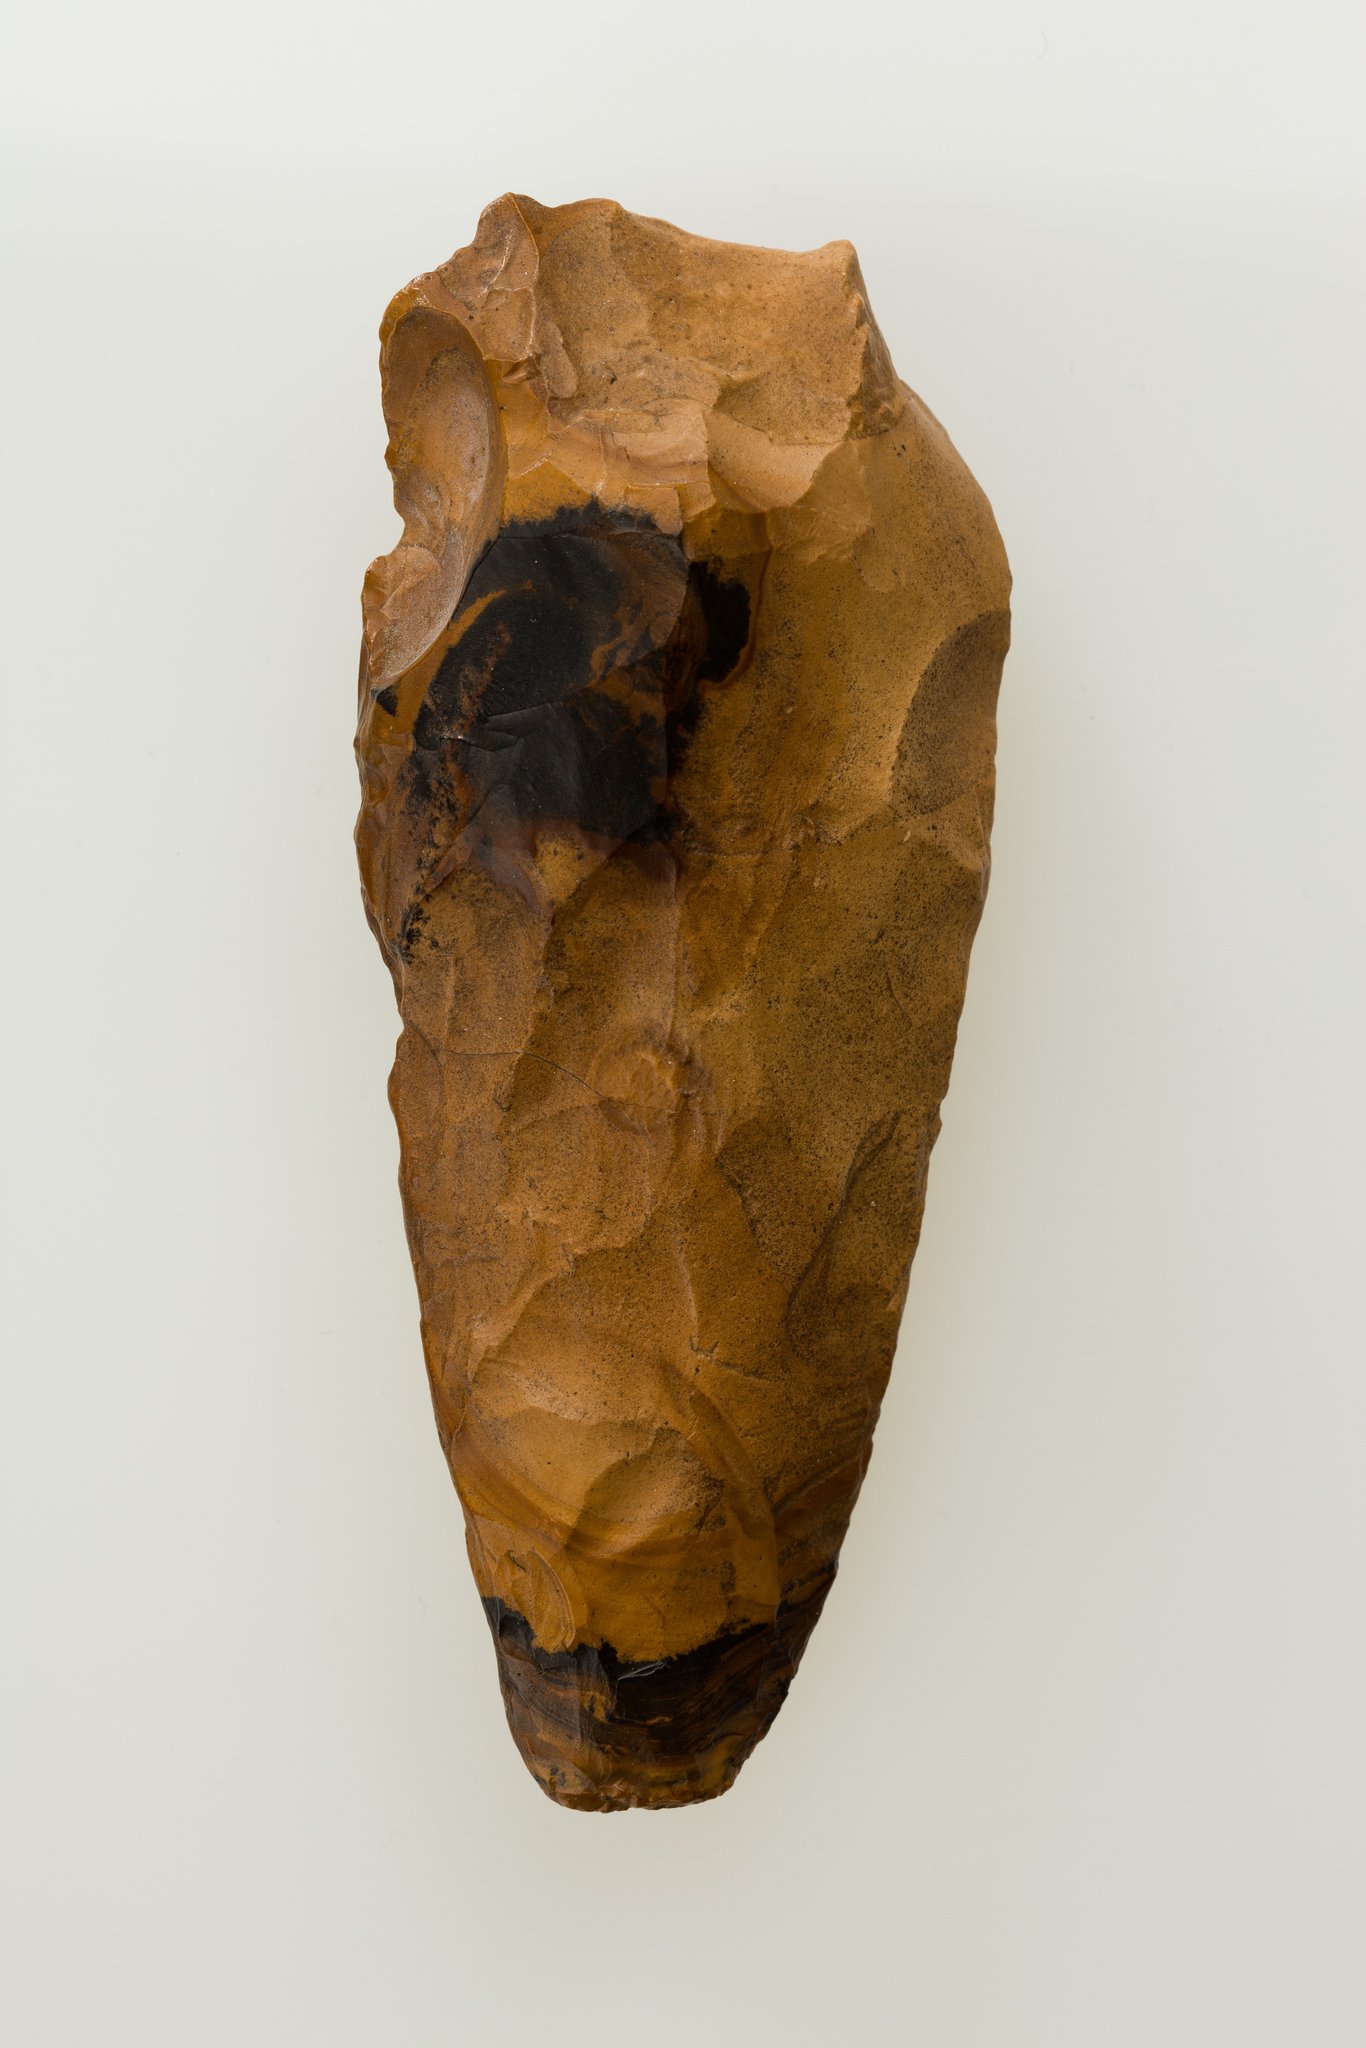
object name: tool, axe, ax, hoe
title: Ax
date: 4500-4000 BCE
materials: stone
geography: egypt